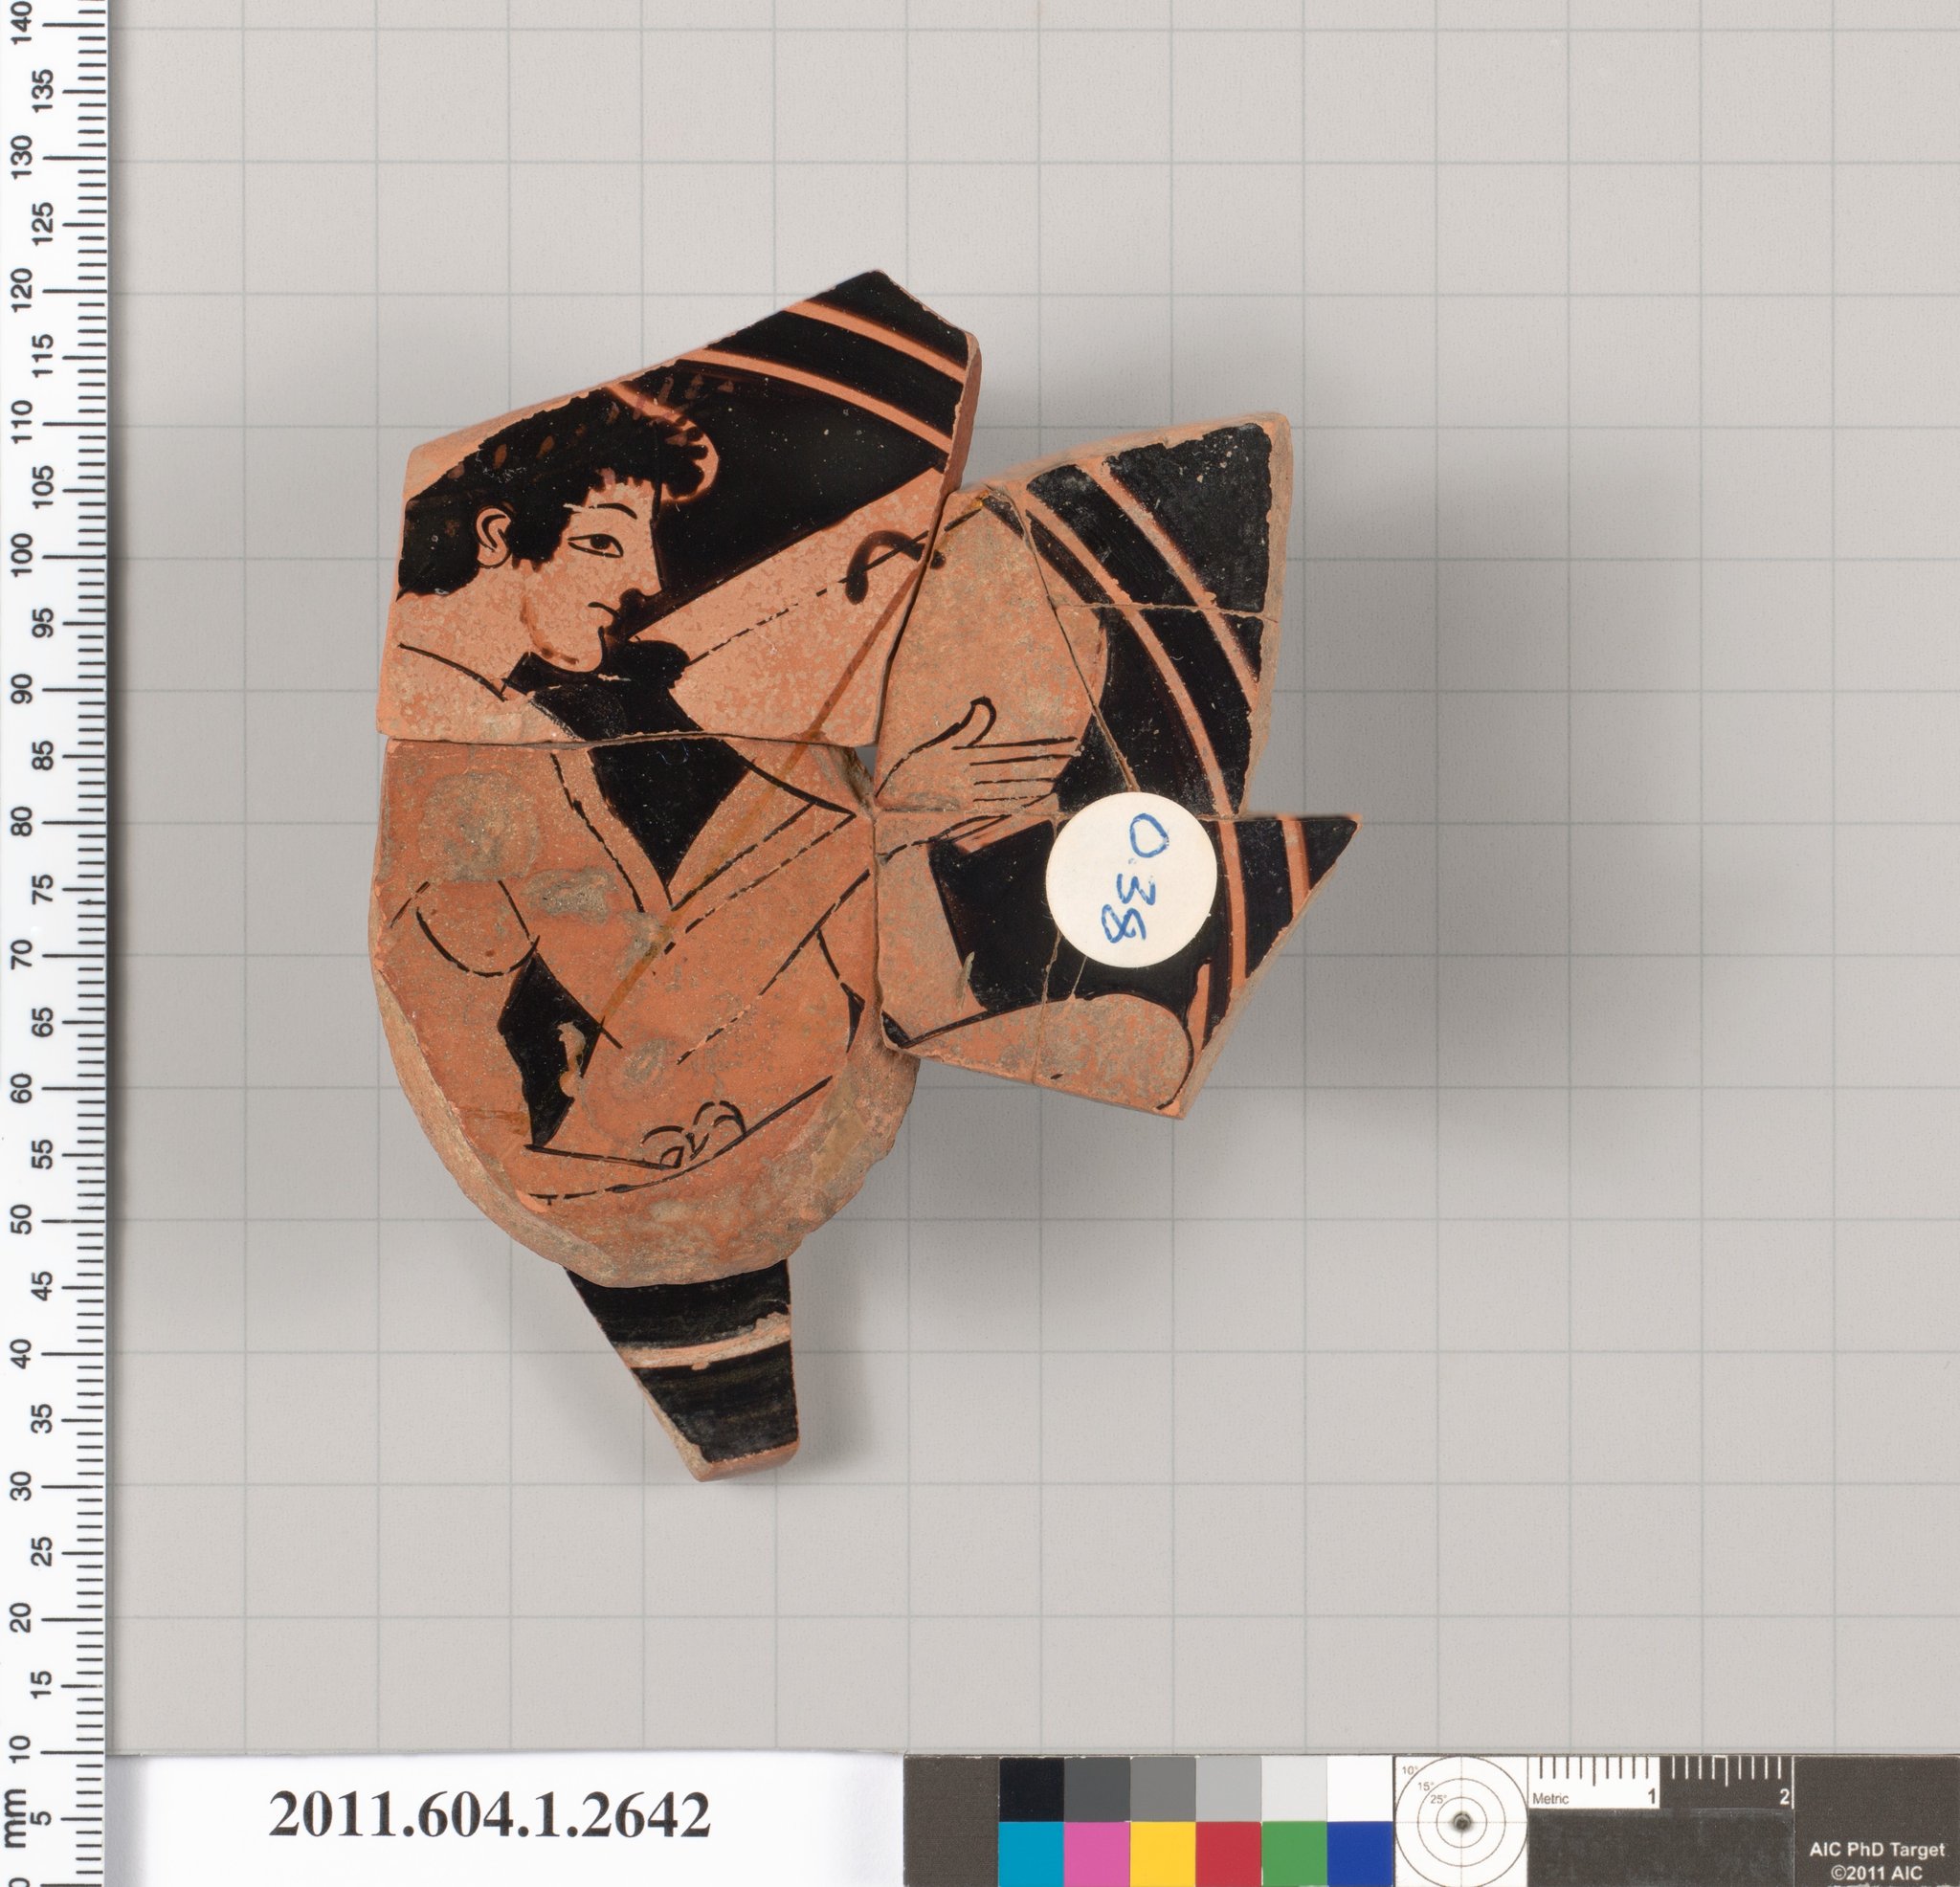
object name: kylix fragment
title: Terracotta fragment of a kylix (drinking cup)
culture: greek, attic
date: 490-480 BCE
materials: terracotta